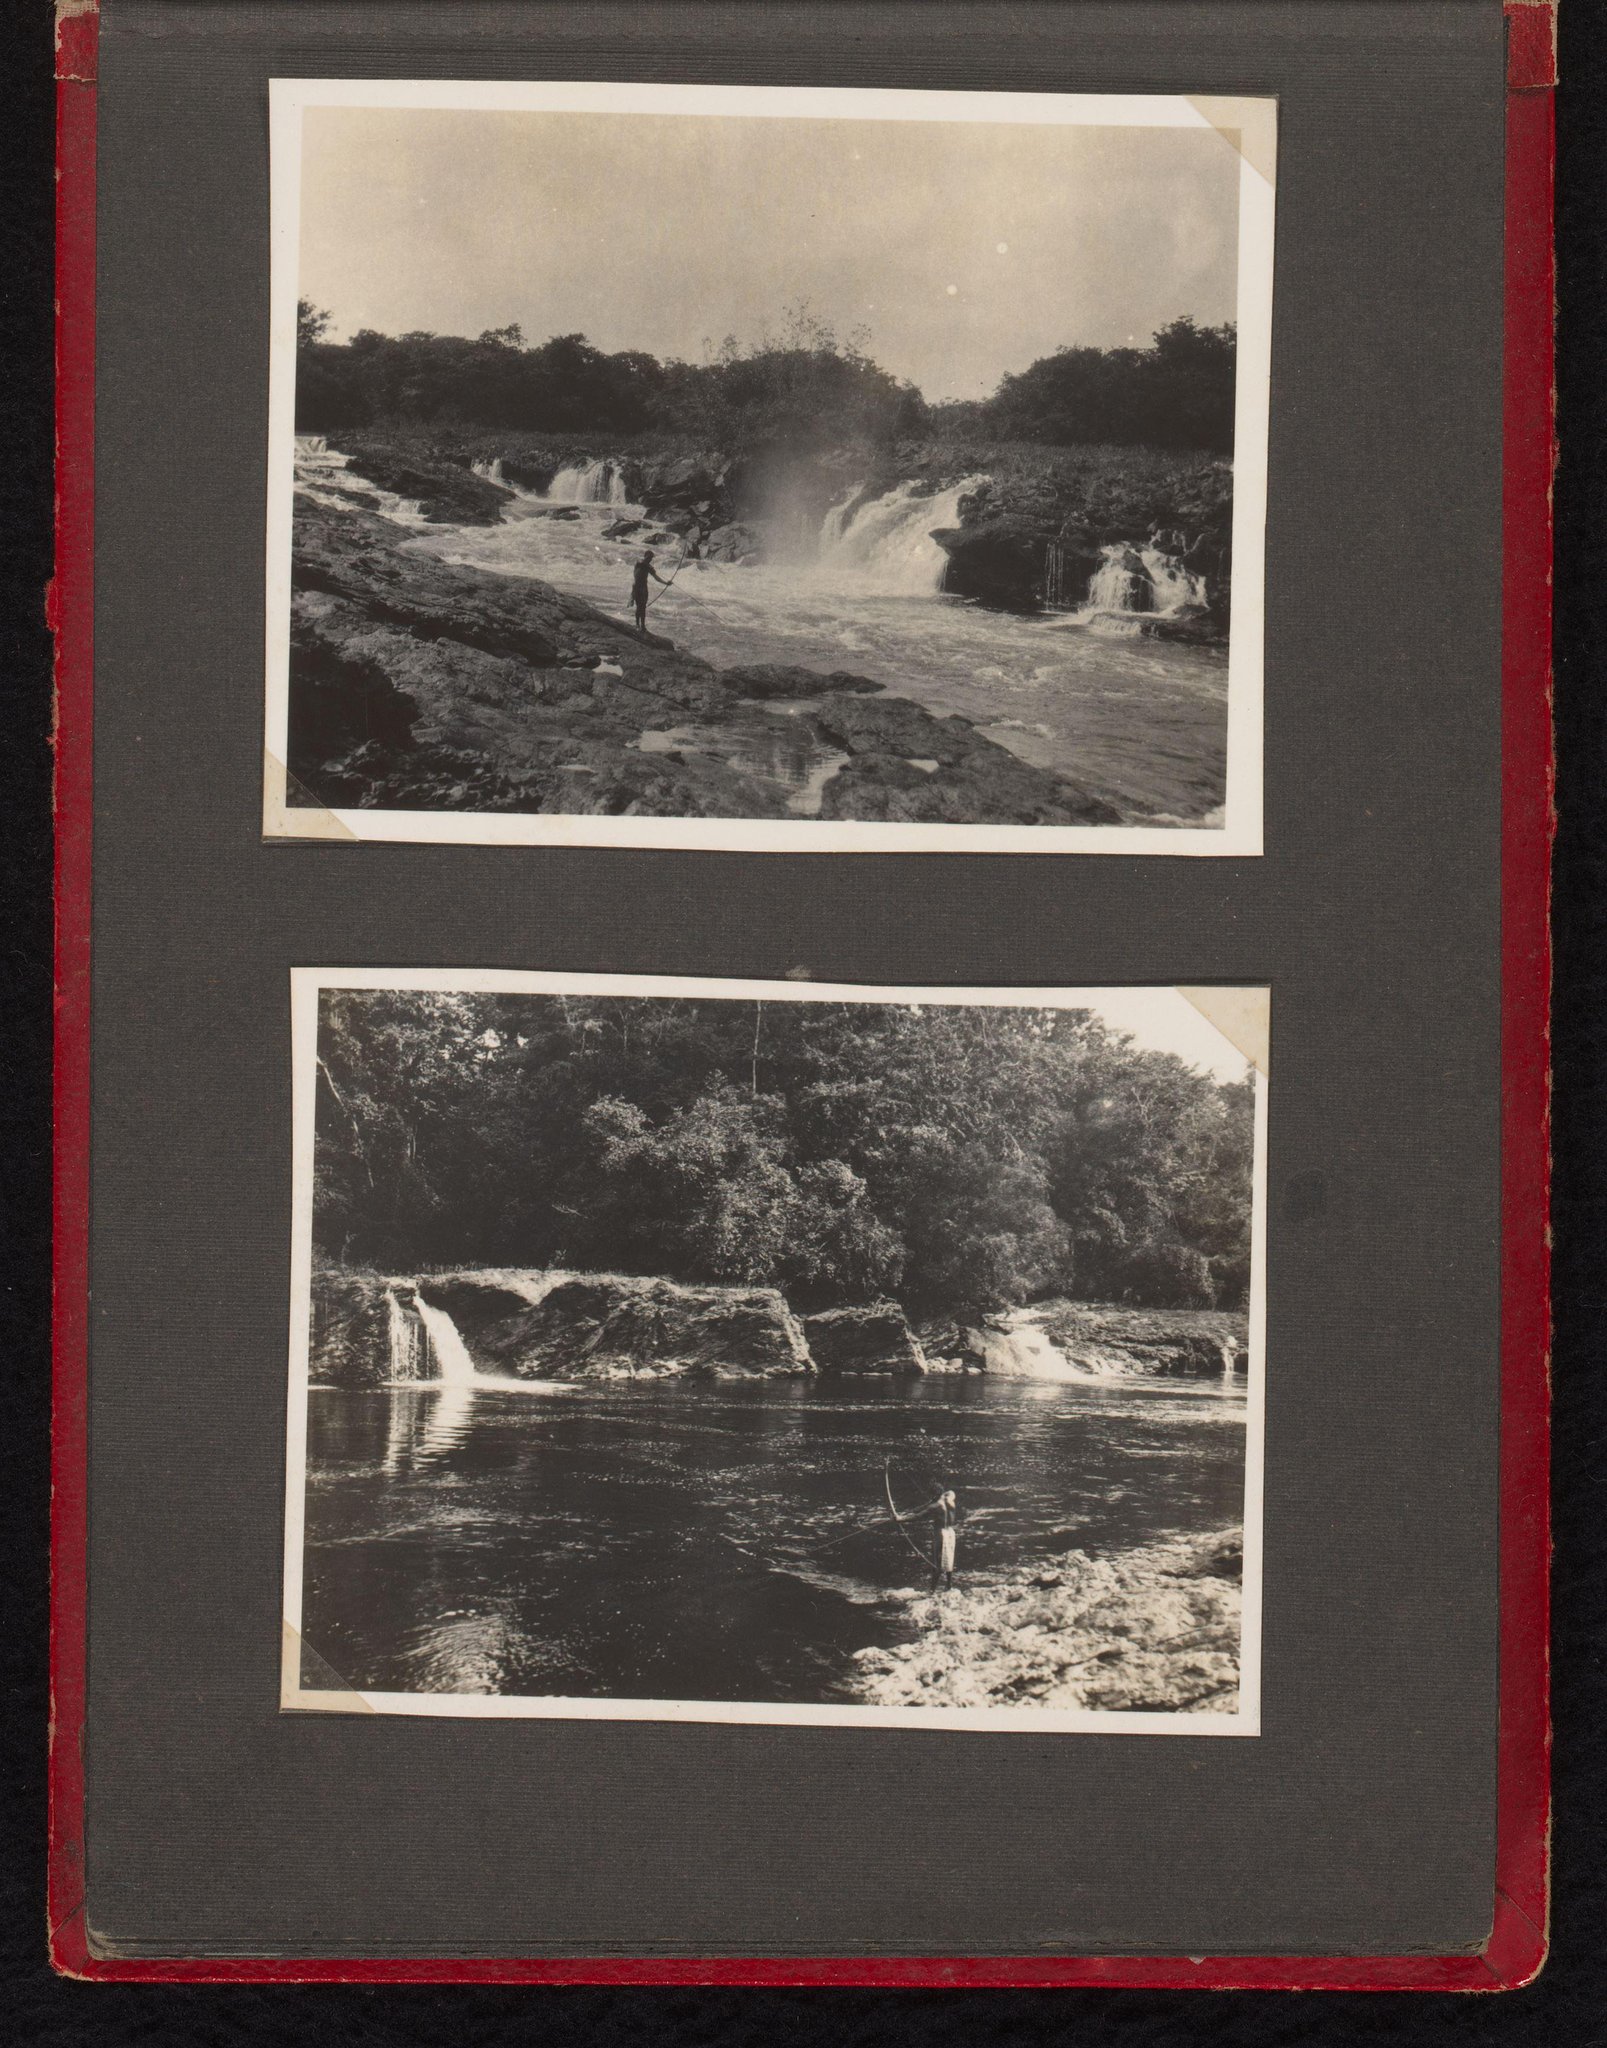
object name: photograph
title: Stroomversnellingen bij Moengo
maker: Anonymous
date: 1925-1935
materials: paper, photographic support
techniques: gelatin silver print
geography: suriname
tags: rapids, archer's weapons: bow and arrow, fresh-water fishery, suriname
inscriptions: name: ‘Leonar 48 / Leonar 28’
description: Albumblad met twee (gekochte) foto's van een met pijl-en-boog jagende visser bij stroomversnelling en watervallen in de rivier Cottica bij Moengo. Onderdeel van het fotoalbum van Theodoor Brouwers over Suriname ca. 1930.